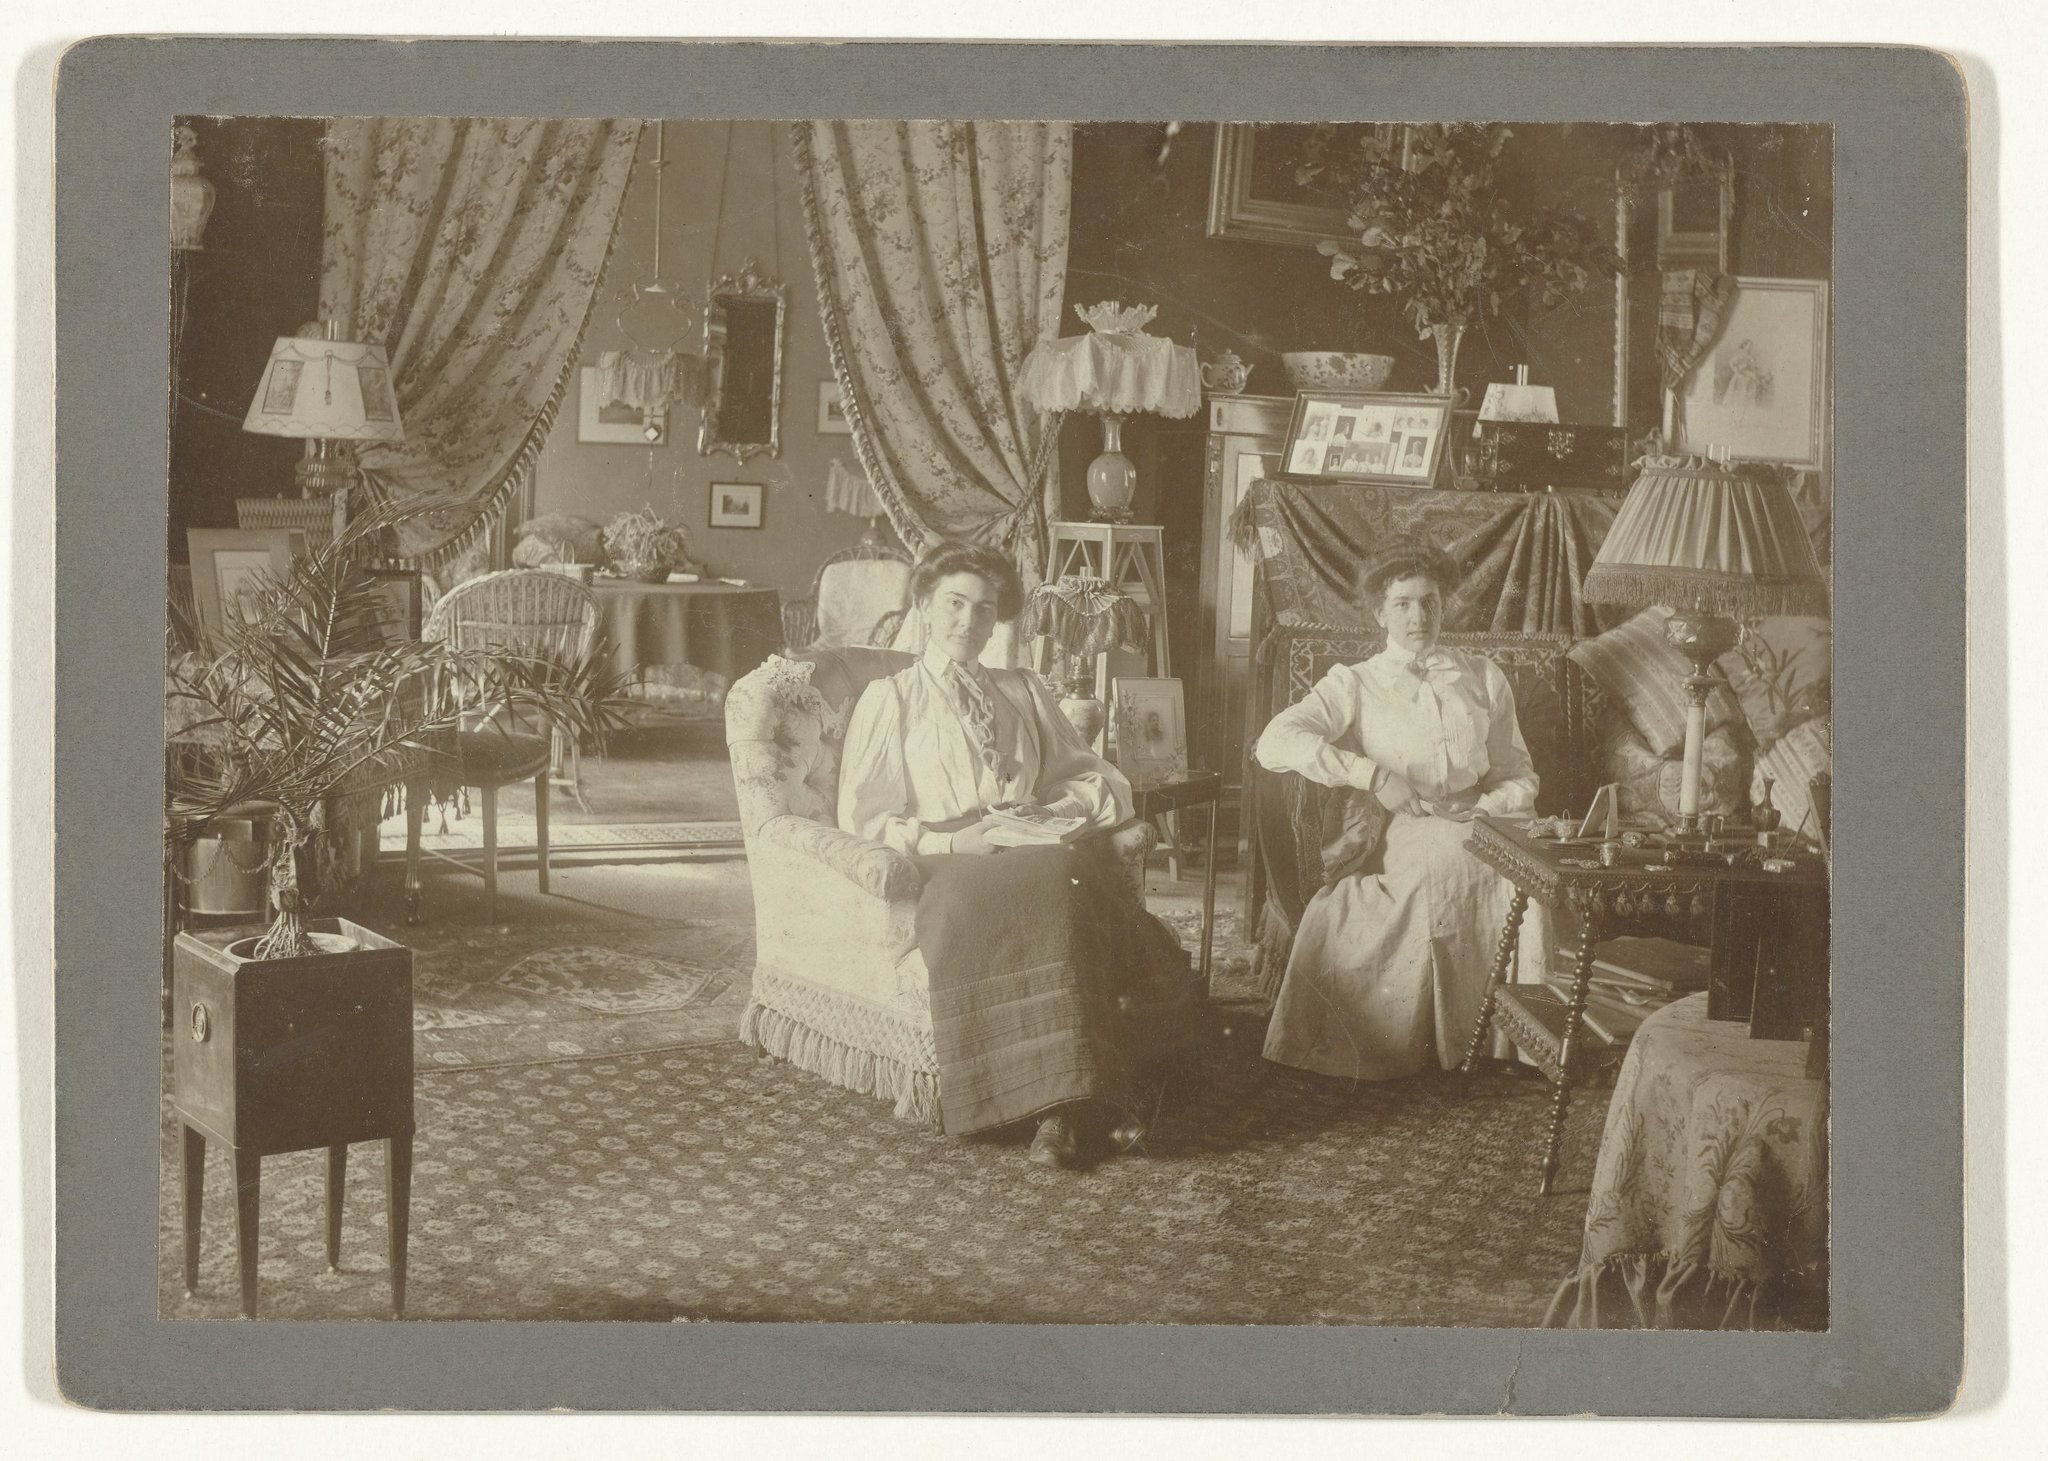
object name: photograph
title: De Kraton Utr. weg in Arnhem nu P.E.G.E.M. gebouw. Huis W.H. v. Braam te Arnhem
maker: Anonymous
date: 1880-1900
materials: paper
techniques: albumen print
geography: netherlands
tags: historical persons (portraits and scenes from the life) - bb - woman, interior of the house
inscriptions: title: ‘De Kraton Utr. weg in Arnhem nu P.E.G.E.M. gebouw. Huis W.H. v. Braam te Arnhem’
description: Het huis van W.H. van Braam in Arnhem wordt ook wel de Kraton genoemd